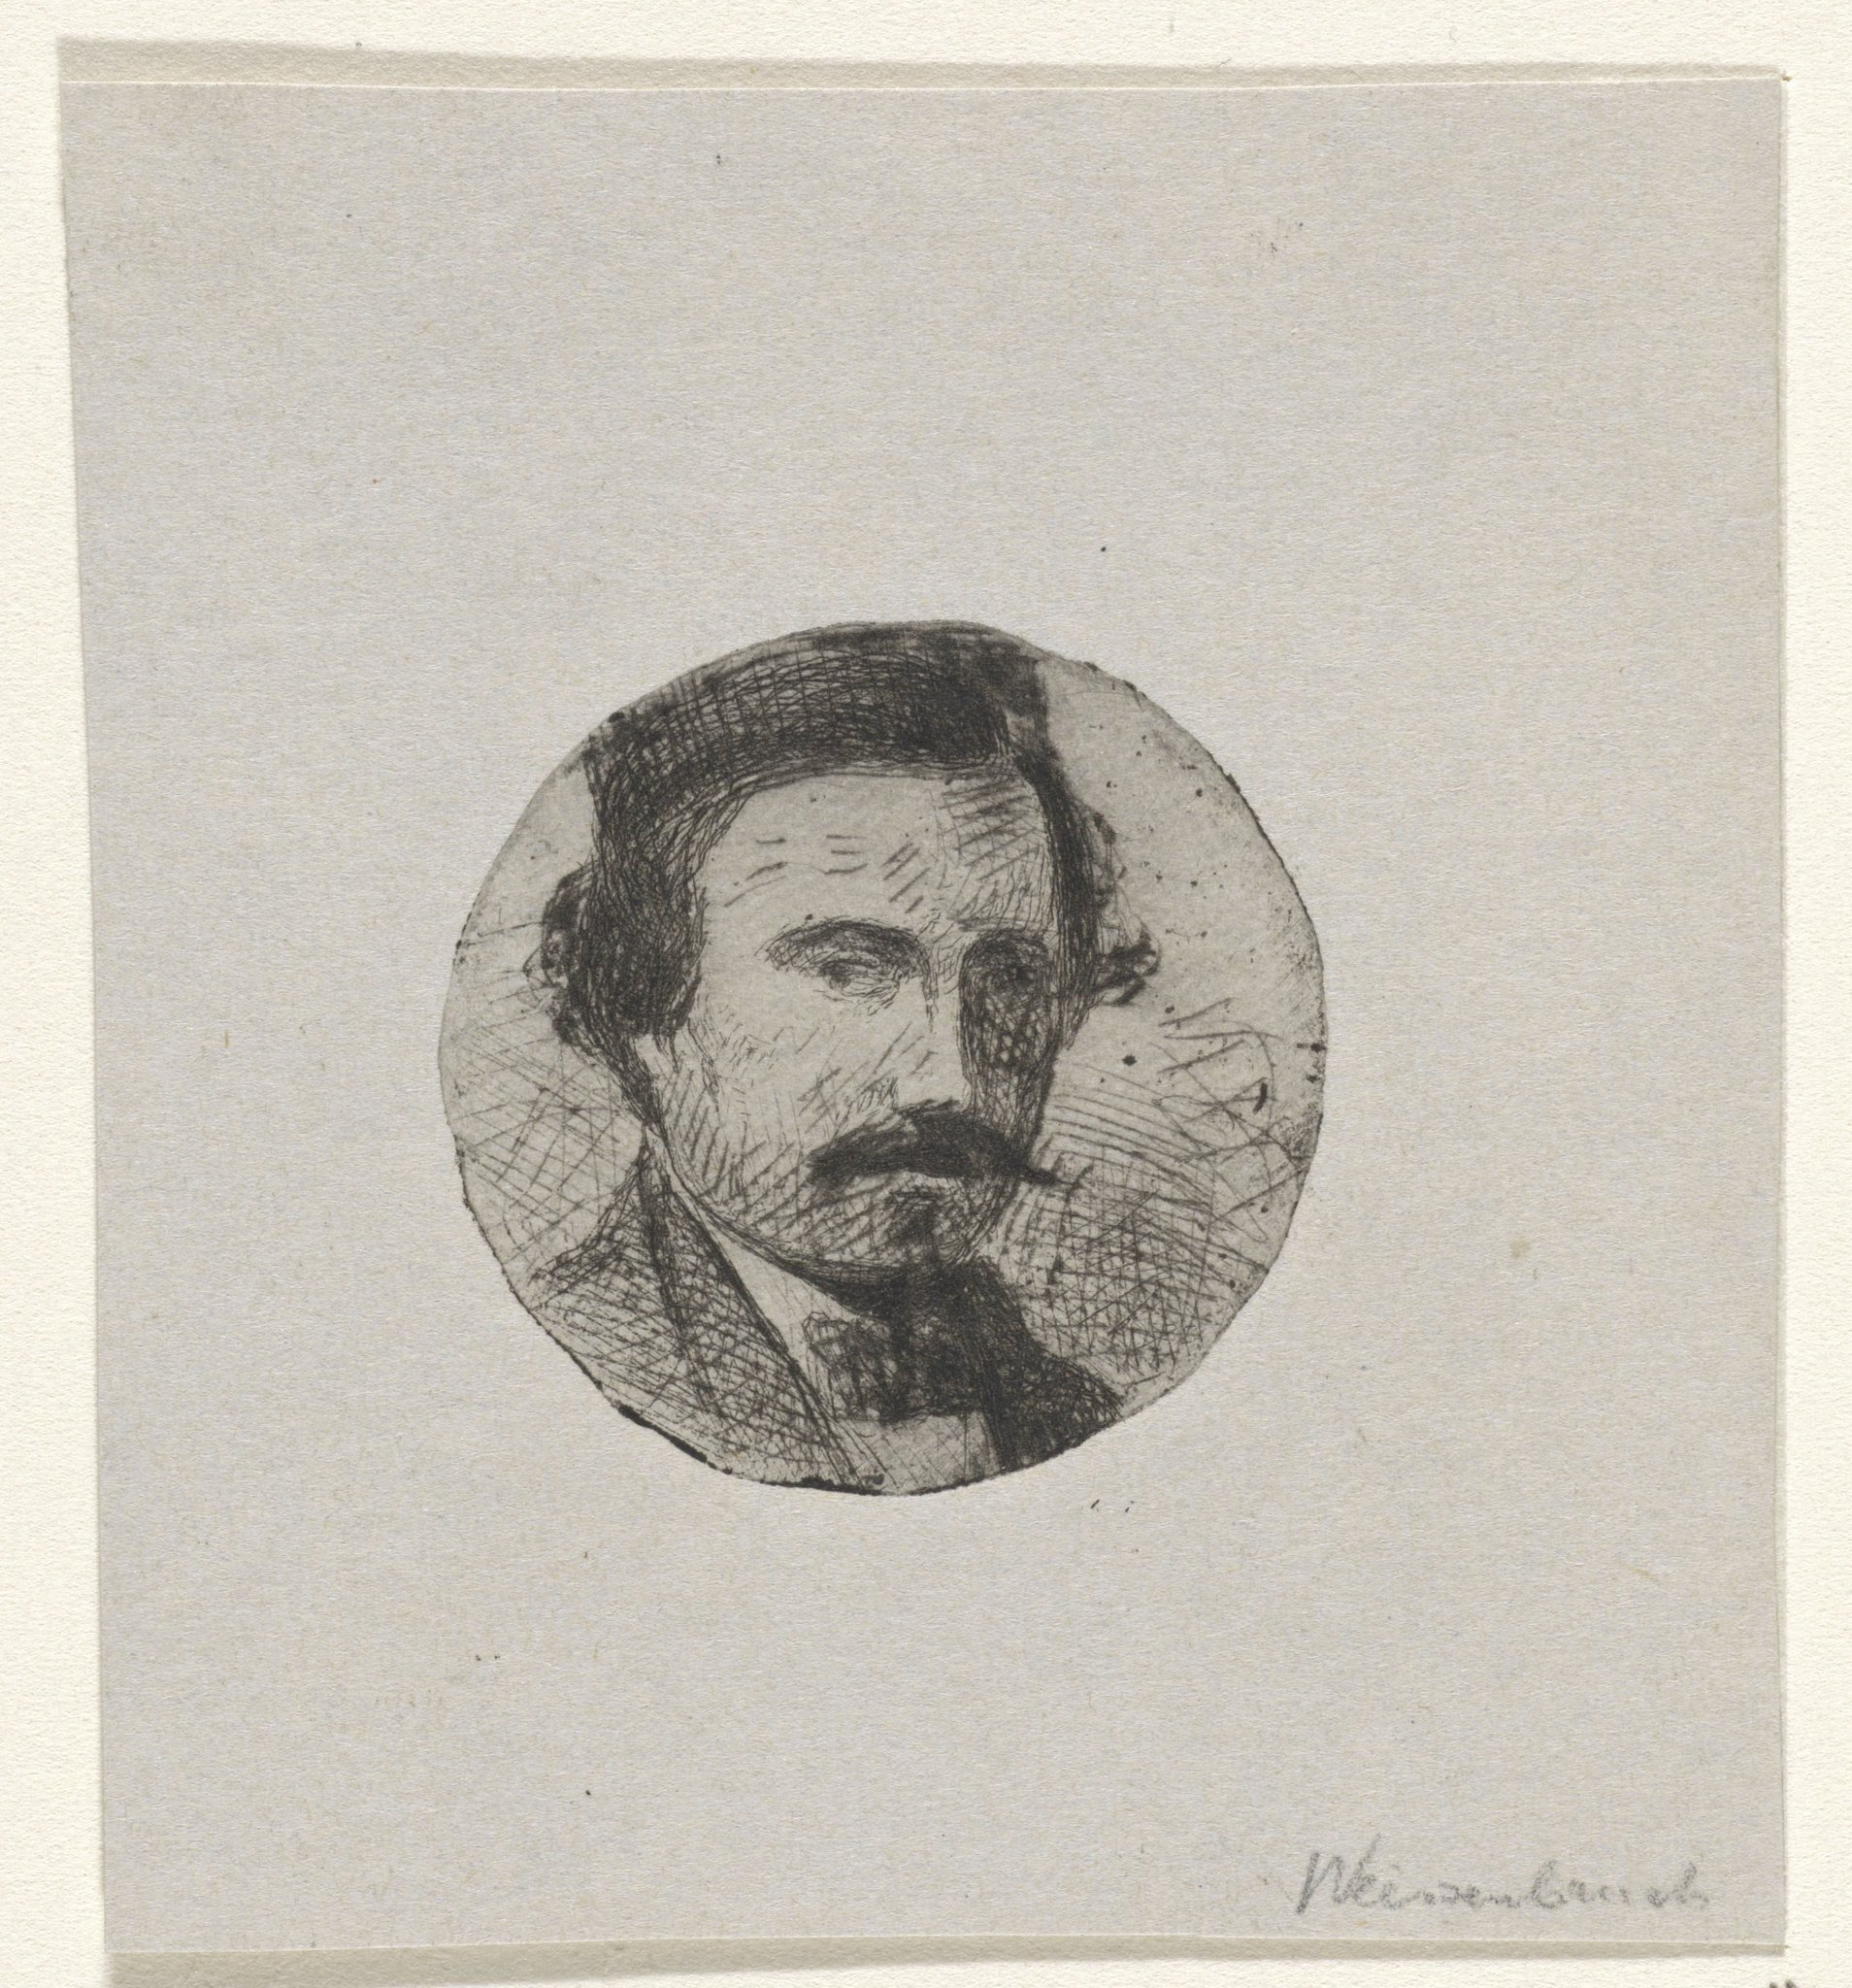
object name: print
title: Portret van Carel Vosmaer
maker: jan weissenbruch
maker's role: painter, print maker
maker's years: 1822-1880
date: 1837-1880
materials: paper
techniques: etching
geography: the hague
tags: draughtsman, carel vosmaer, historical persons, portrait, self-portrait of artist